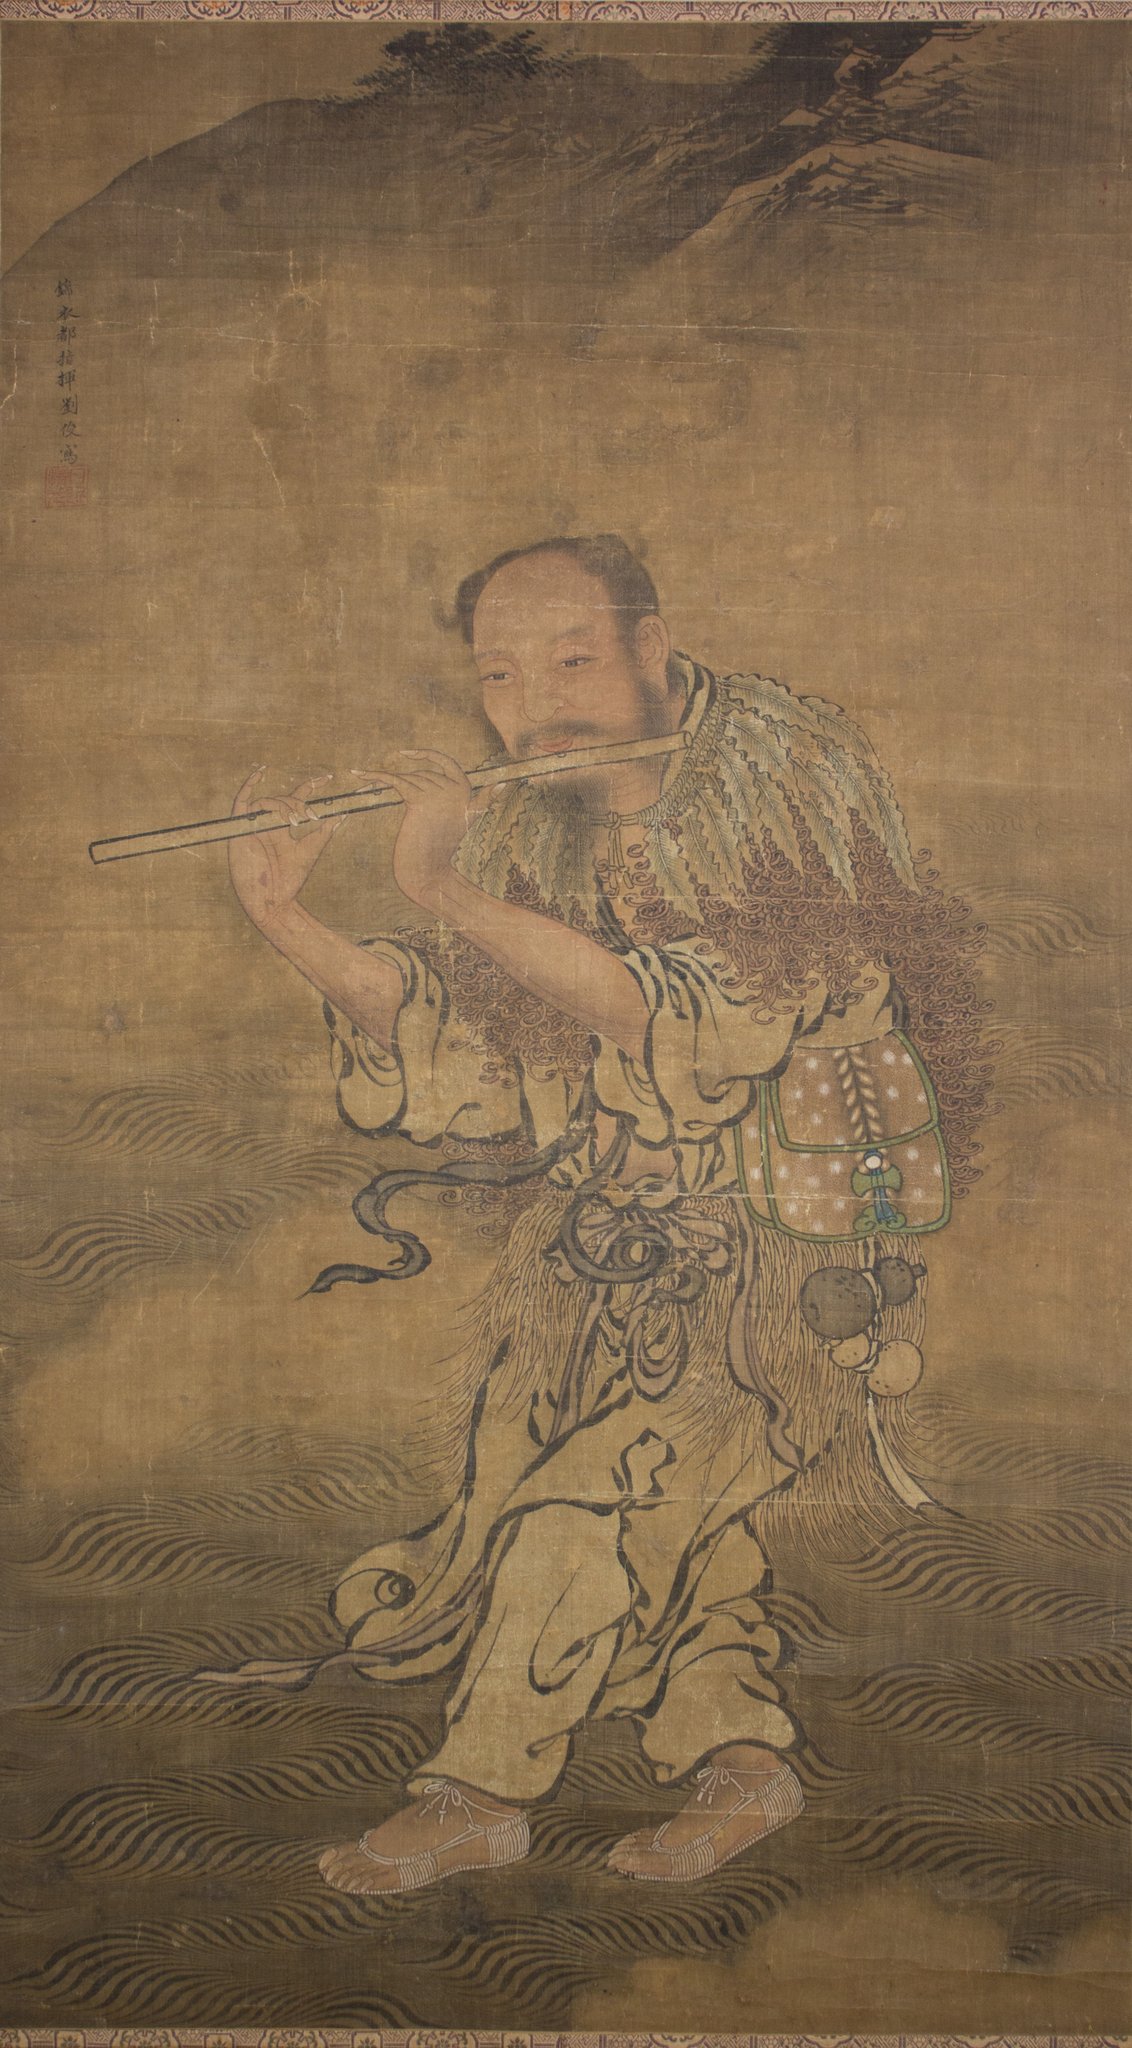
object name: hanging scroll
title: The Daoist Immortal Han Xiangzi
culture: chinese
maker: liu jun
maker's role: artist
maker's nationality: chinese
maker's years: 1475-1505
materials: ink, silk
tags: men,flutes,musicians